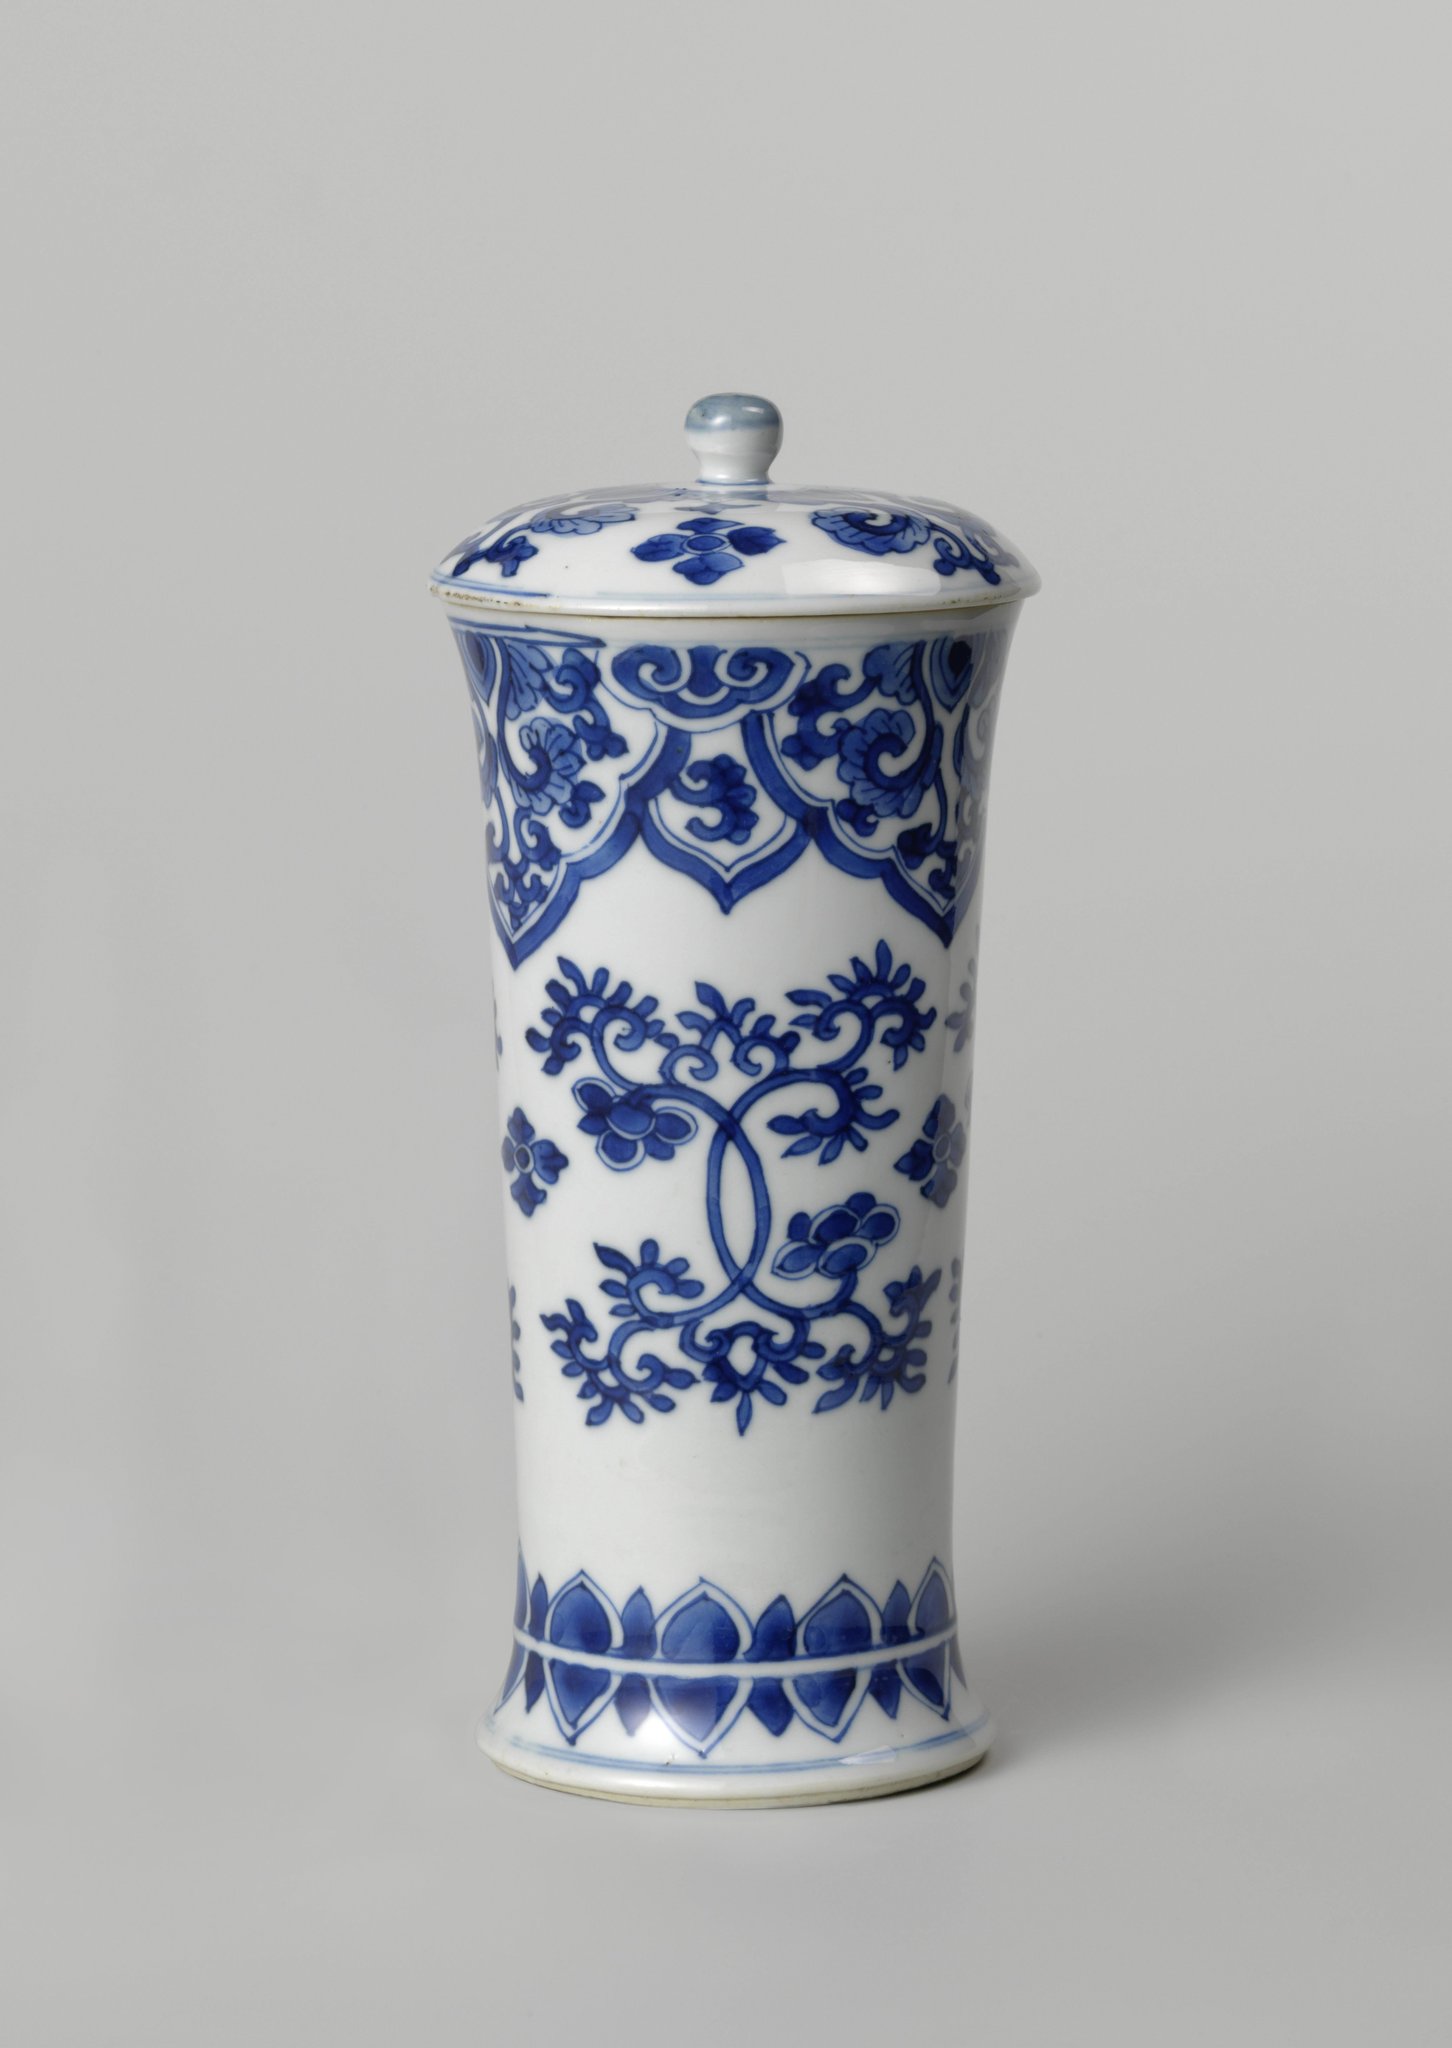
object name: vase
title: Covered cylindrical beaker with flower scrolls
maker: Anonymous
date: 1700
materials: glaze, paint, porcelain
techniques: firing, turning, vitrification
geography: china